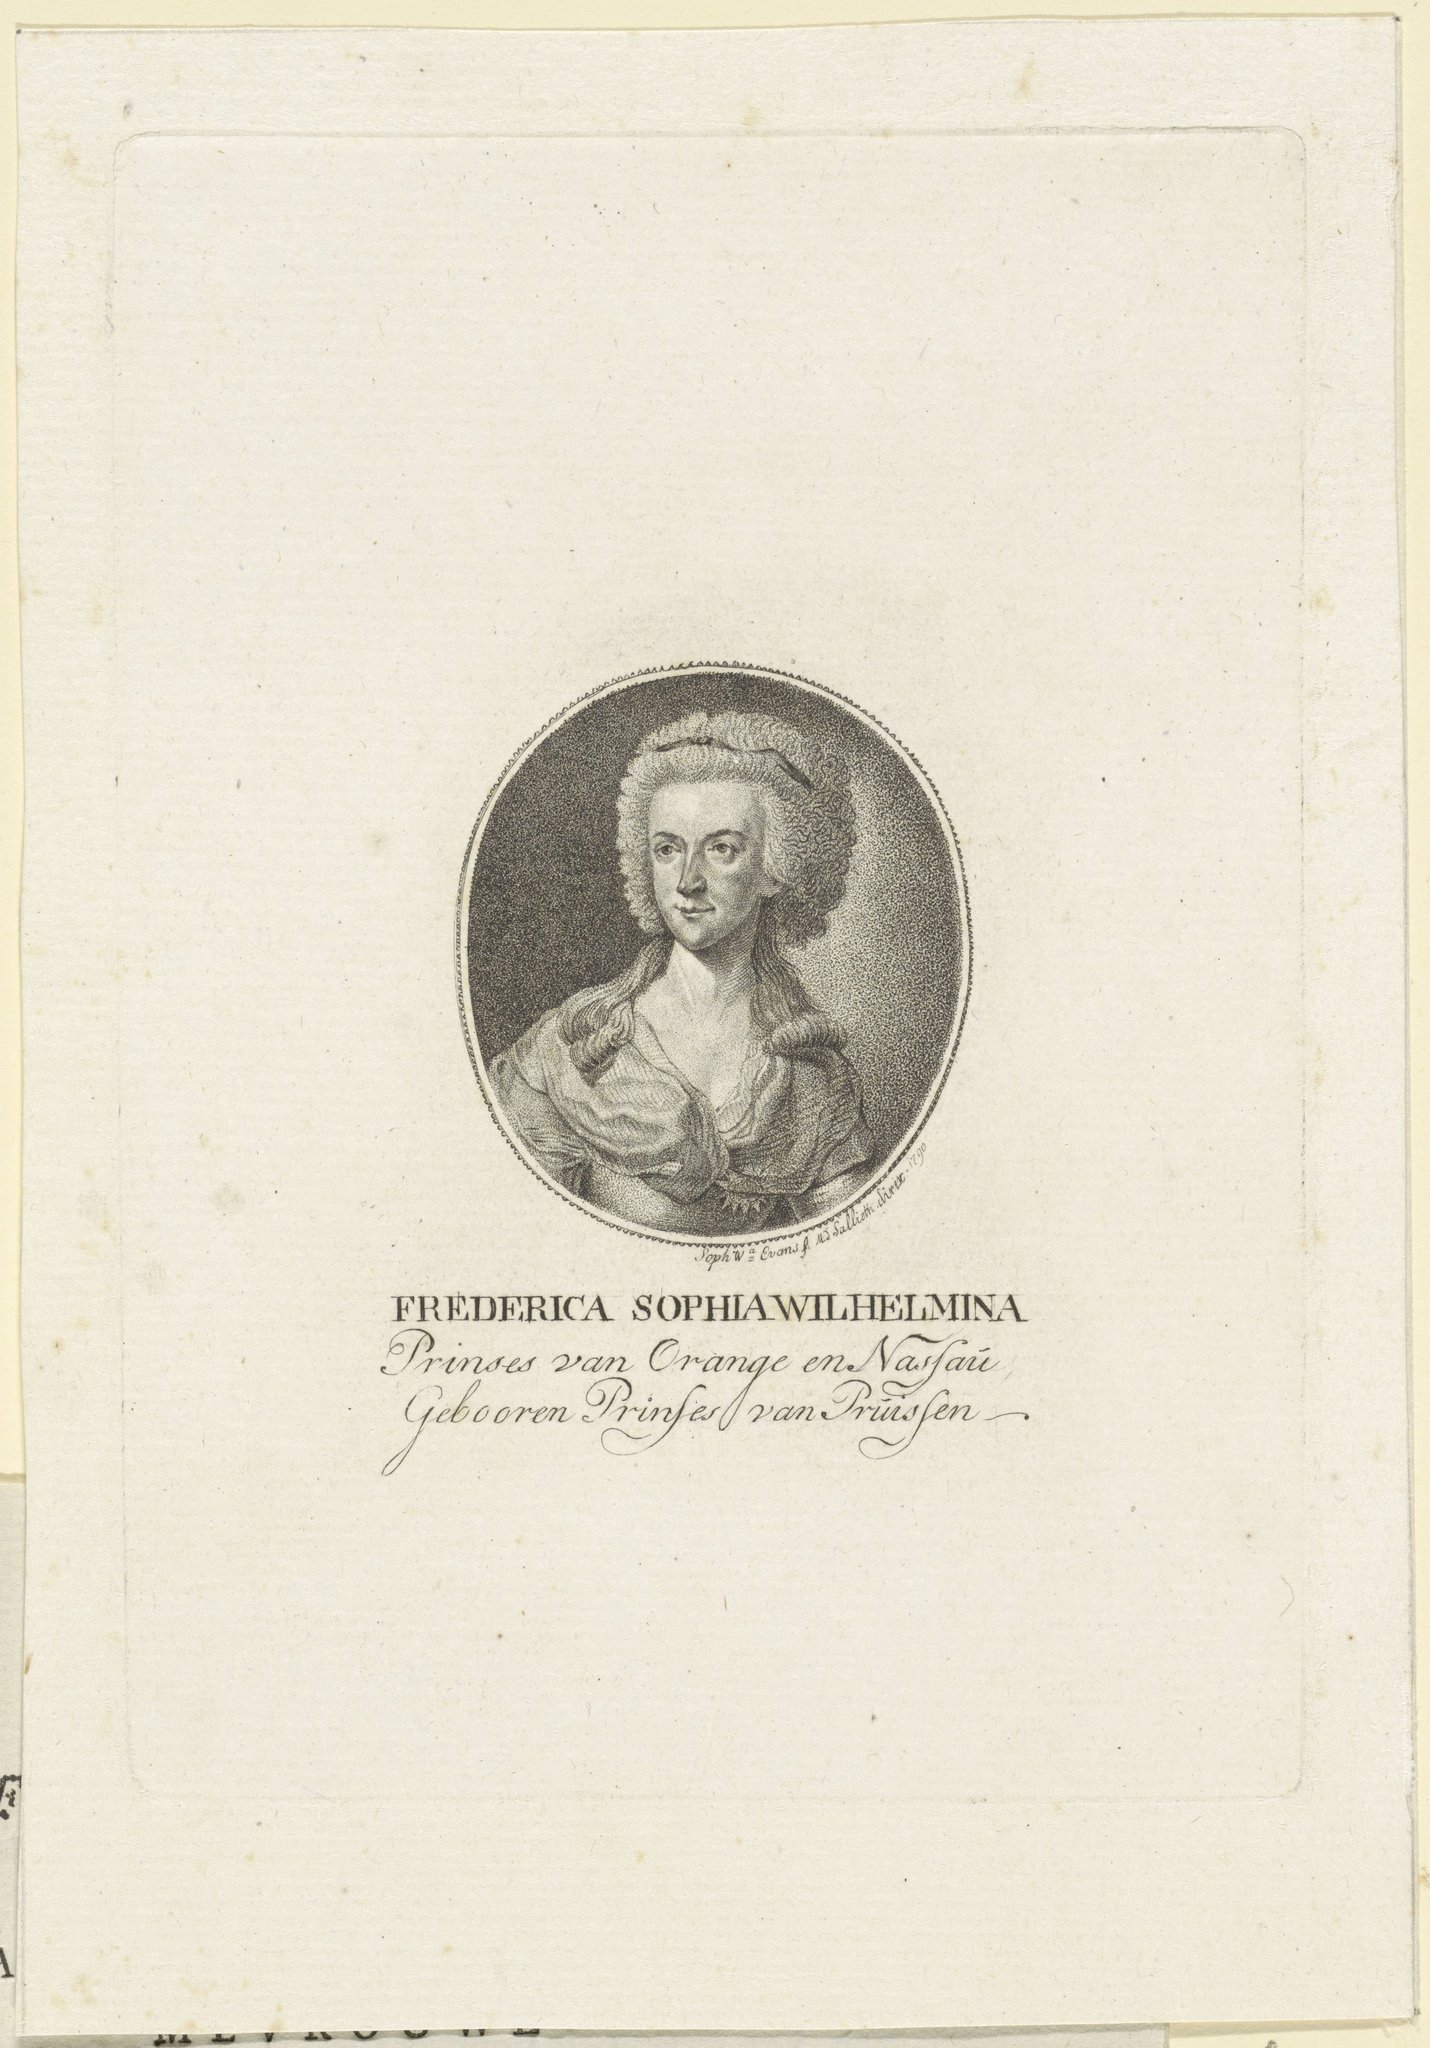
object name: print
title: Portret van Wilhelmina van Pruisen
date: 1790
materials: paper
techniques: engraving, etching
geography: northern netherlands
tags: berlin, painter, draughtsman, wilhelmina of prussia (princess of orange)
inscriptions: date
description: Portret van Wilhelmina in een ovaal. In de ondermarge haar naam en titels. Losse verklarende tekst in boekdruk.